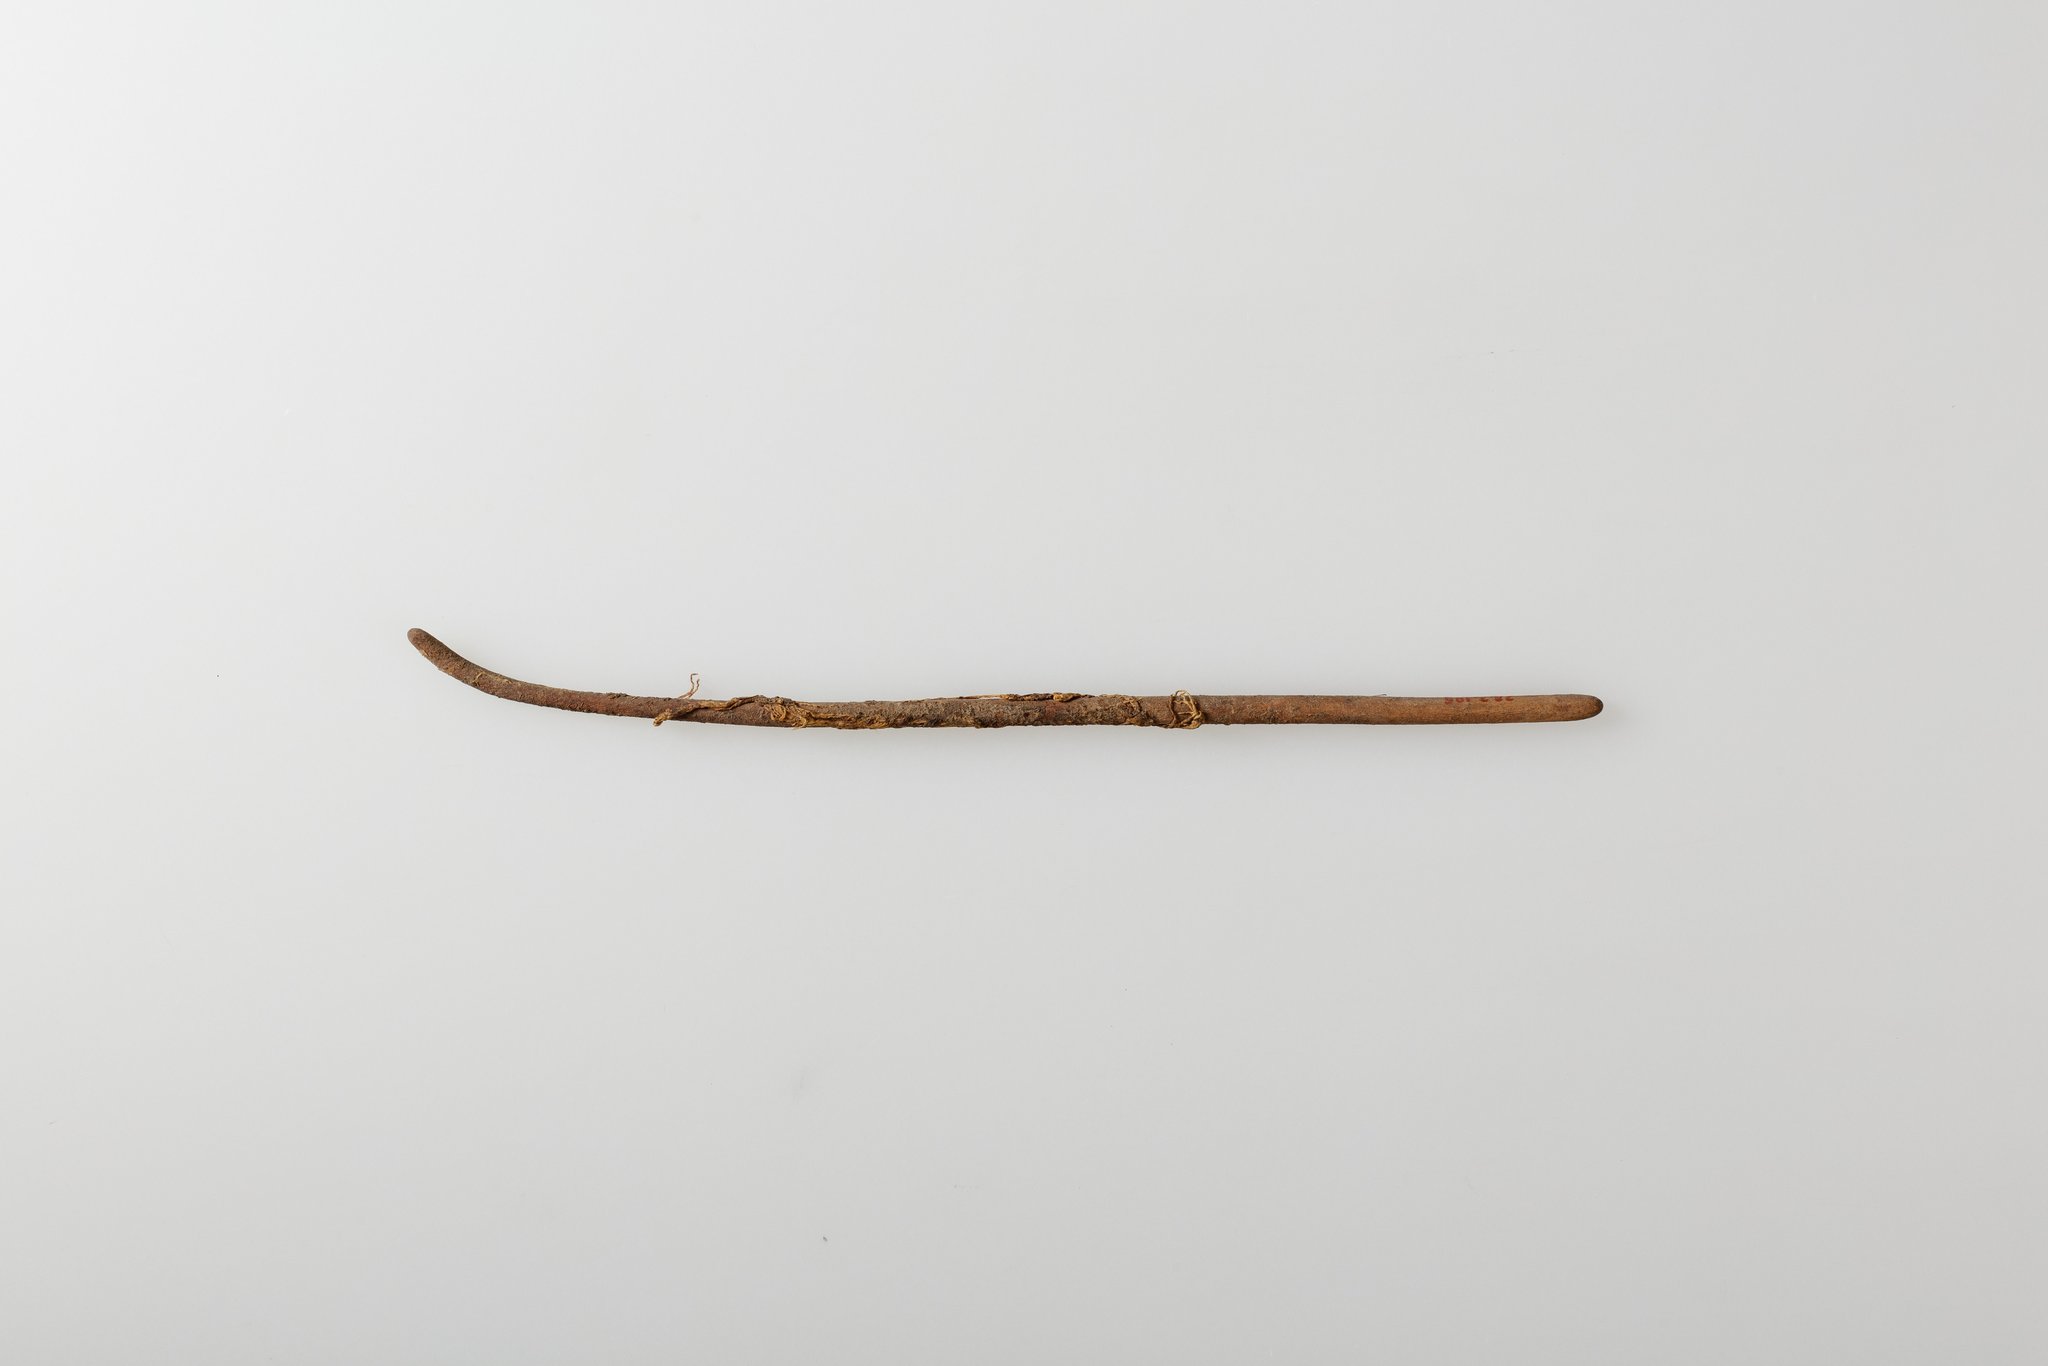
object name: embalming tool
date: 945-525 BCE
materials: wood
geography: egypt